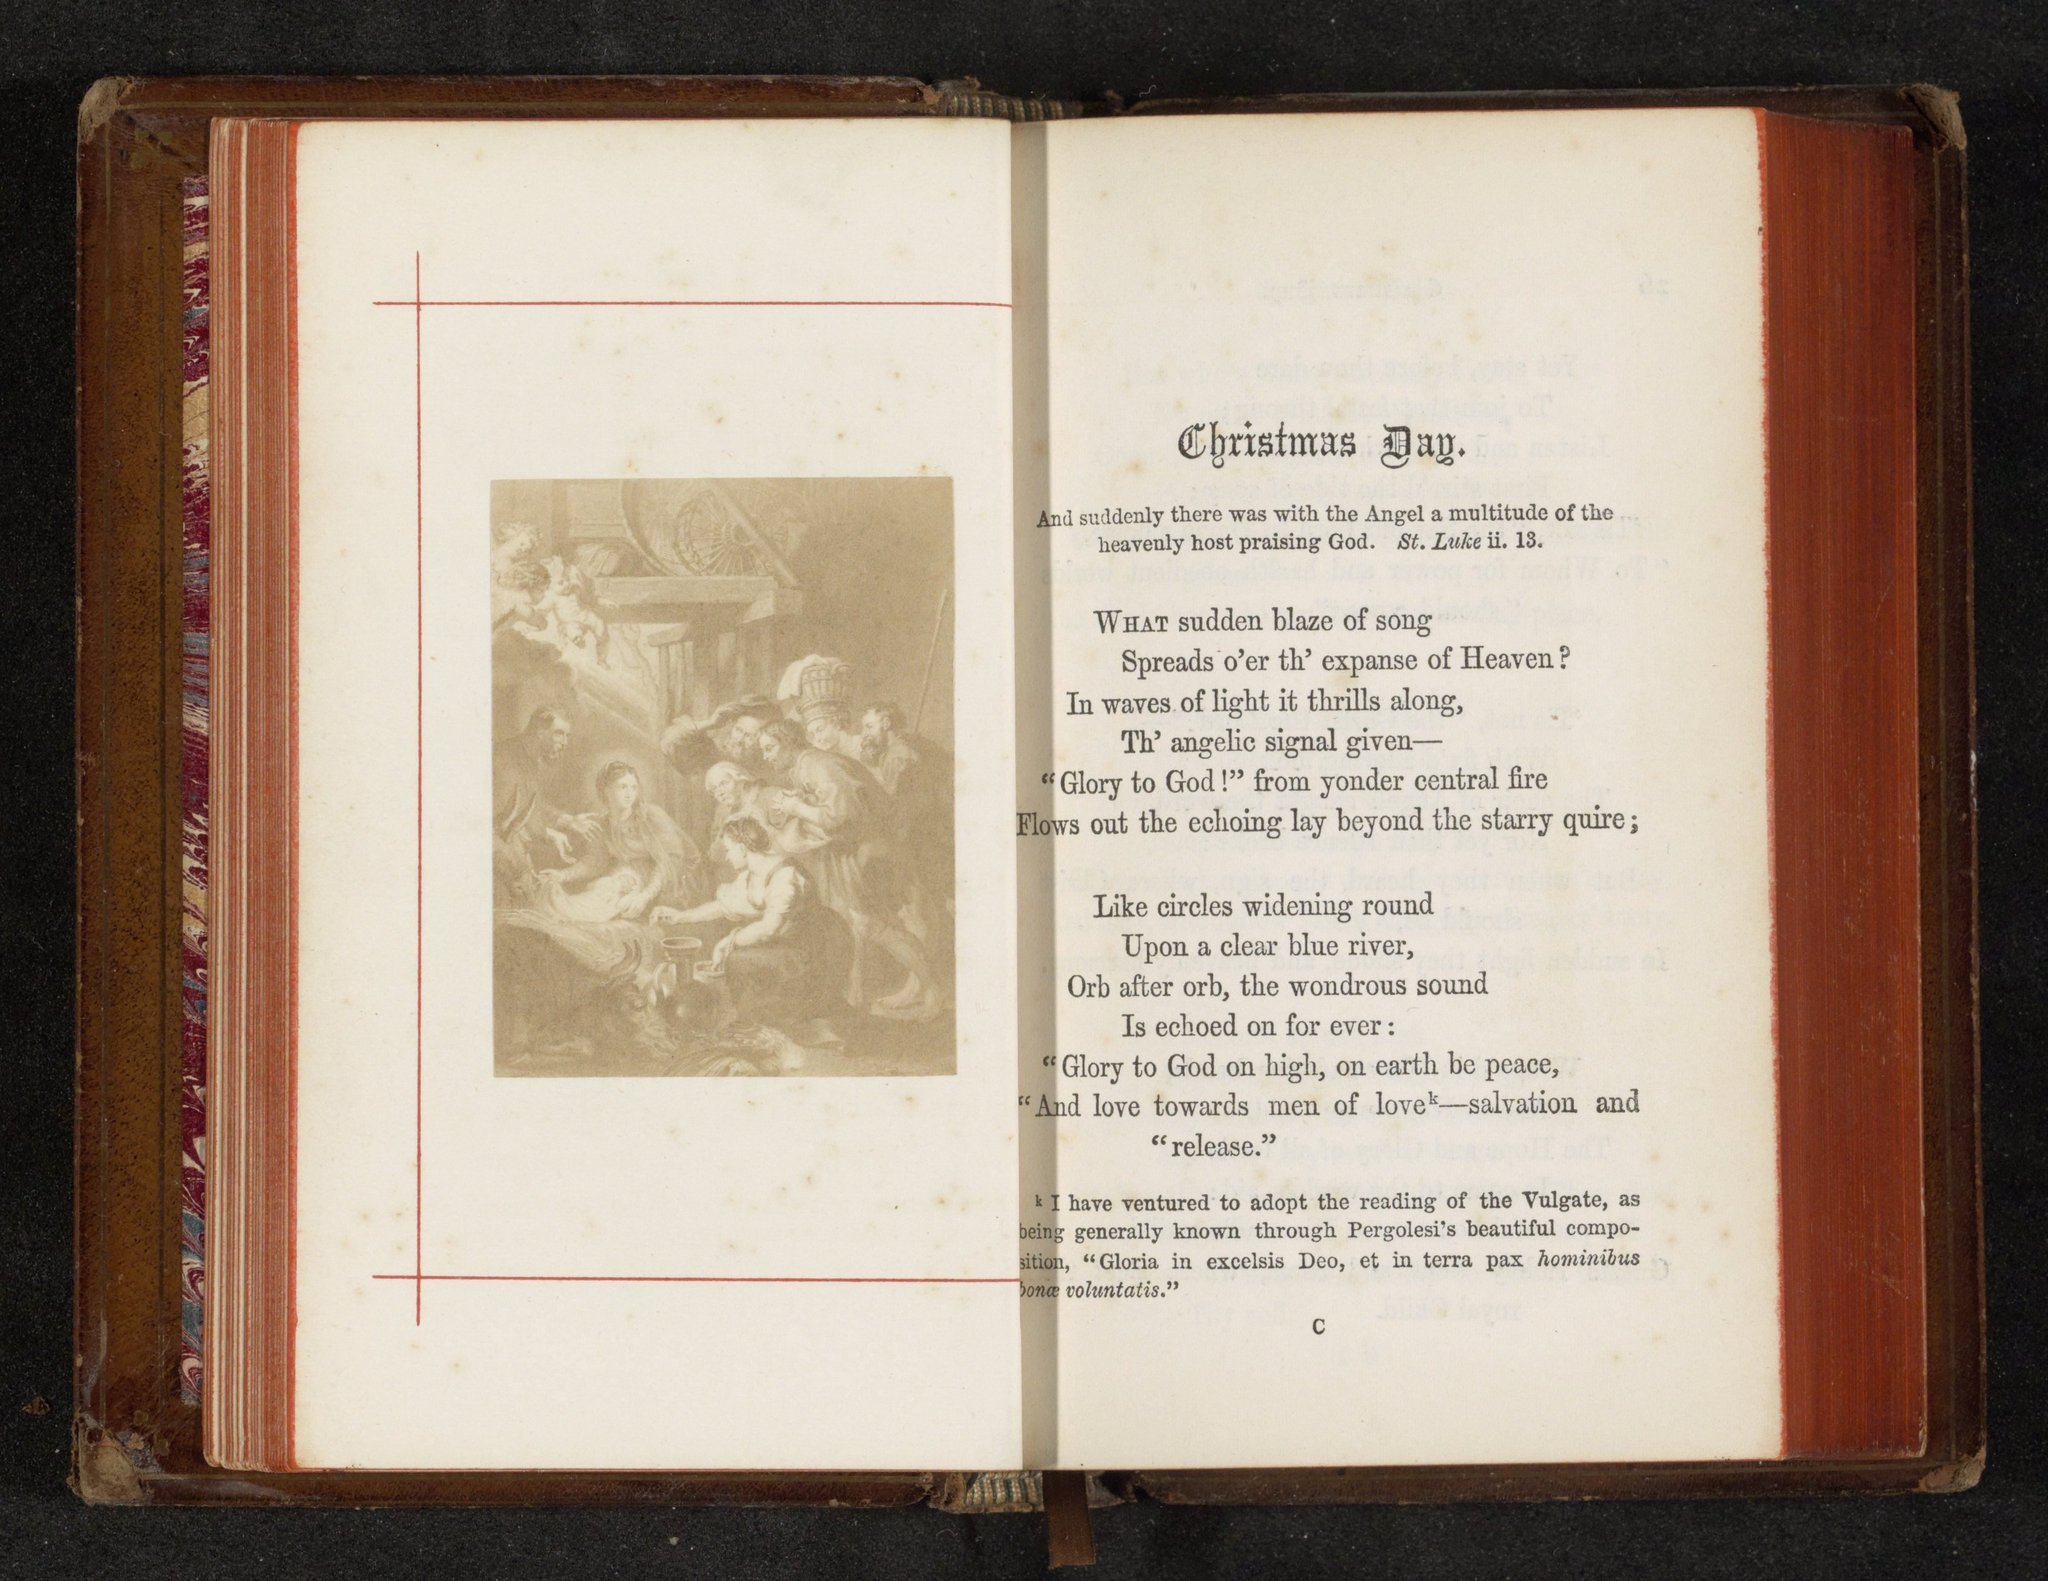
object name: page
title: Fotoreproductie van een schilderij, voorstellende de aanbidding der herders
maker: Anonymous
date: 1865-1870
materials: photographic support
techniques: albumen print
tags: adoration of the christ-child by the shepherds; mary and joseph present